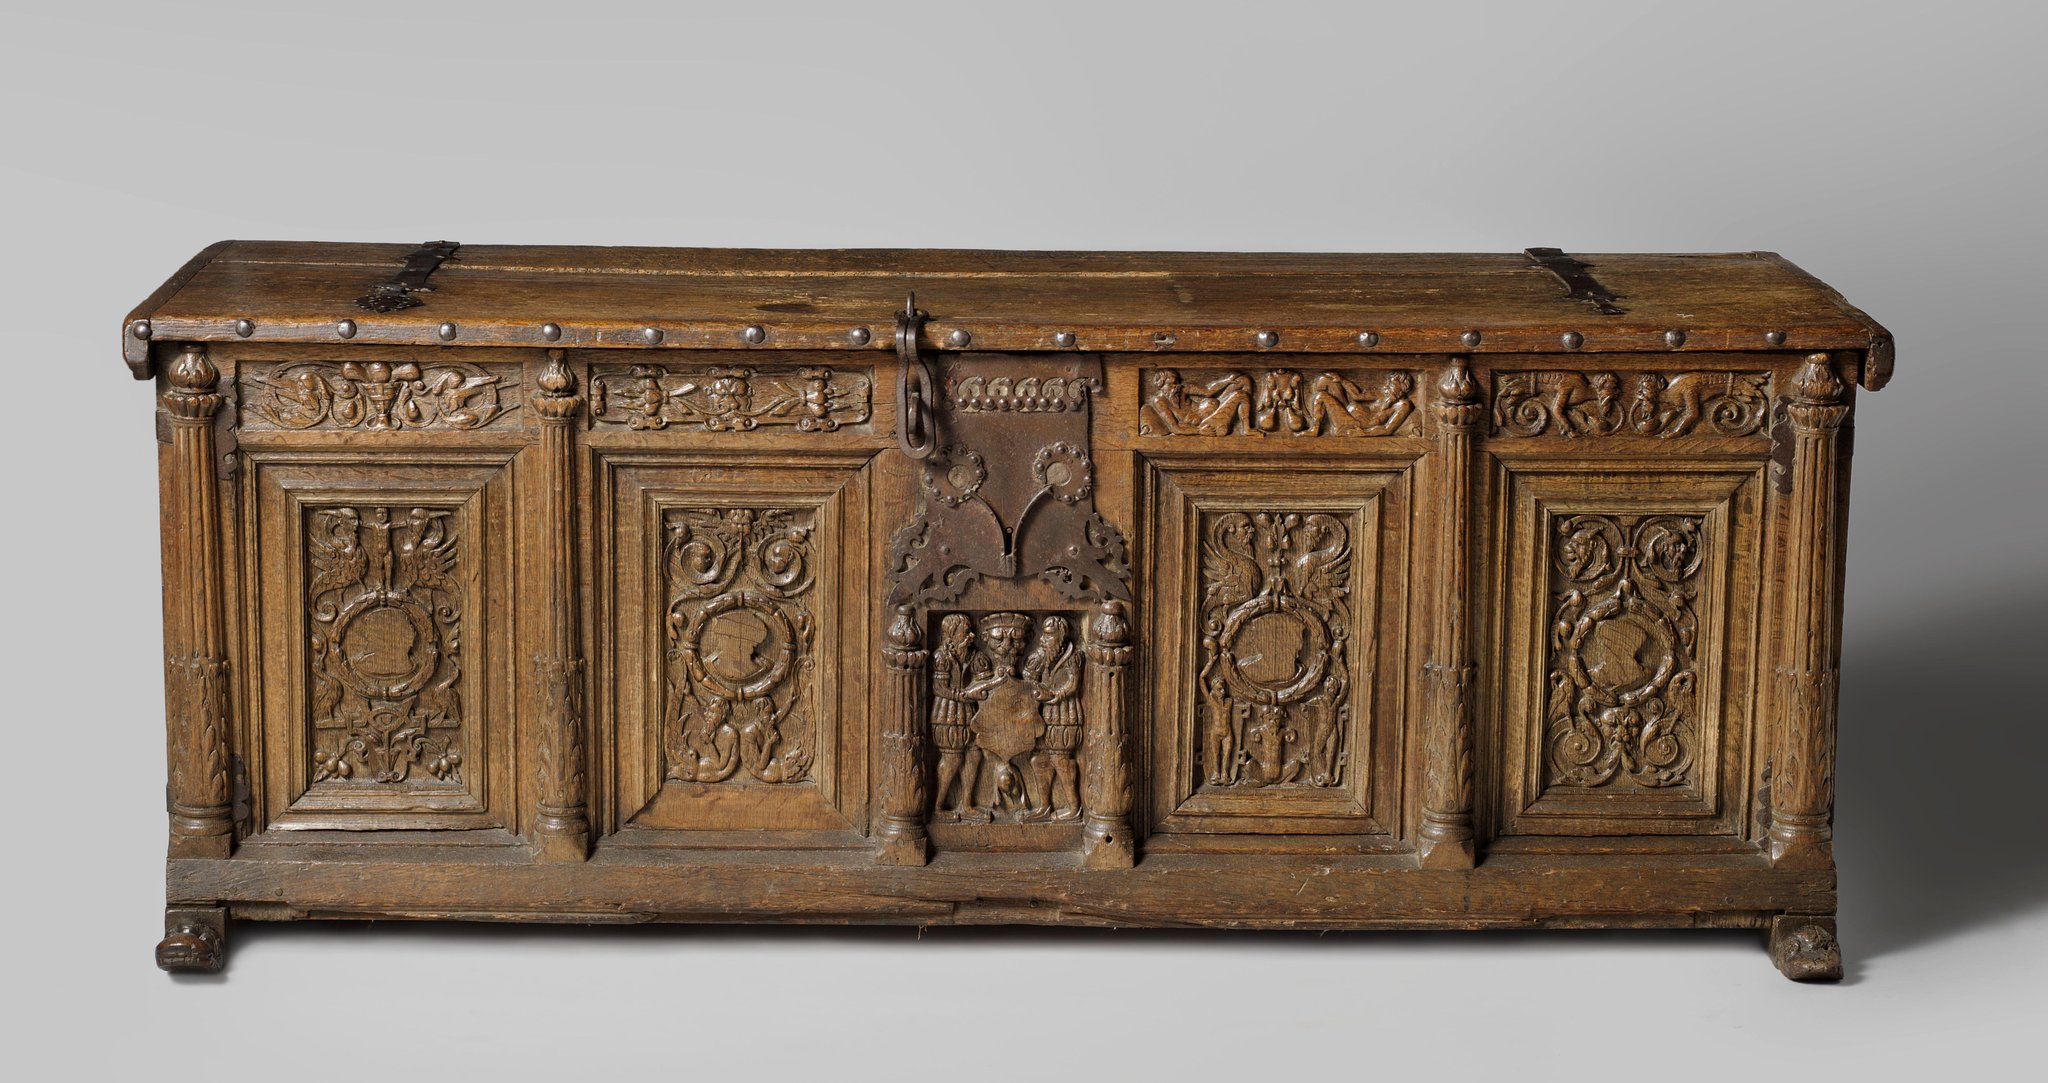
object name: case furniture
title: Kist waarvan het voorbord is versierd met grotesken gegroepeerd rondom medaillons met koppen, binnen lauwerkransen.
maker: Anonymous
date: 1500-1550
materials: iron, leather, wood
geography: northern netherlands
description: Chest. Oak. Netherlands(?), c. 1550.